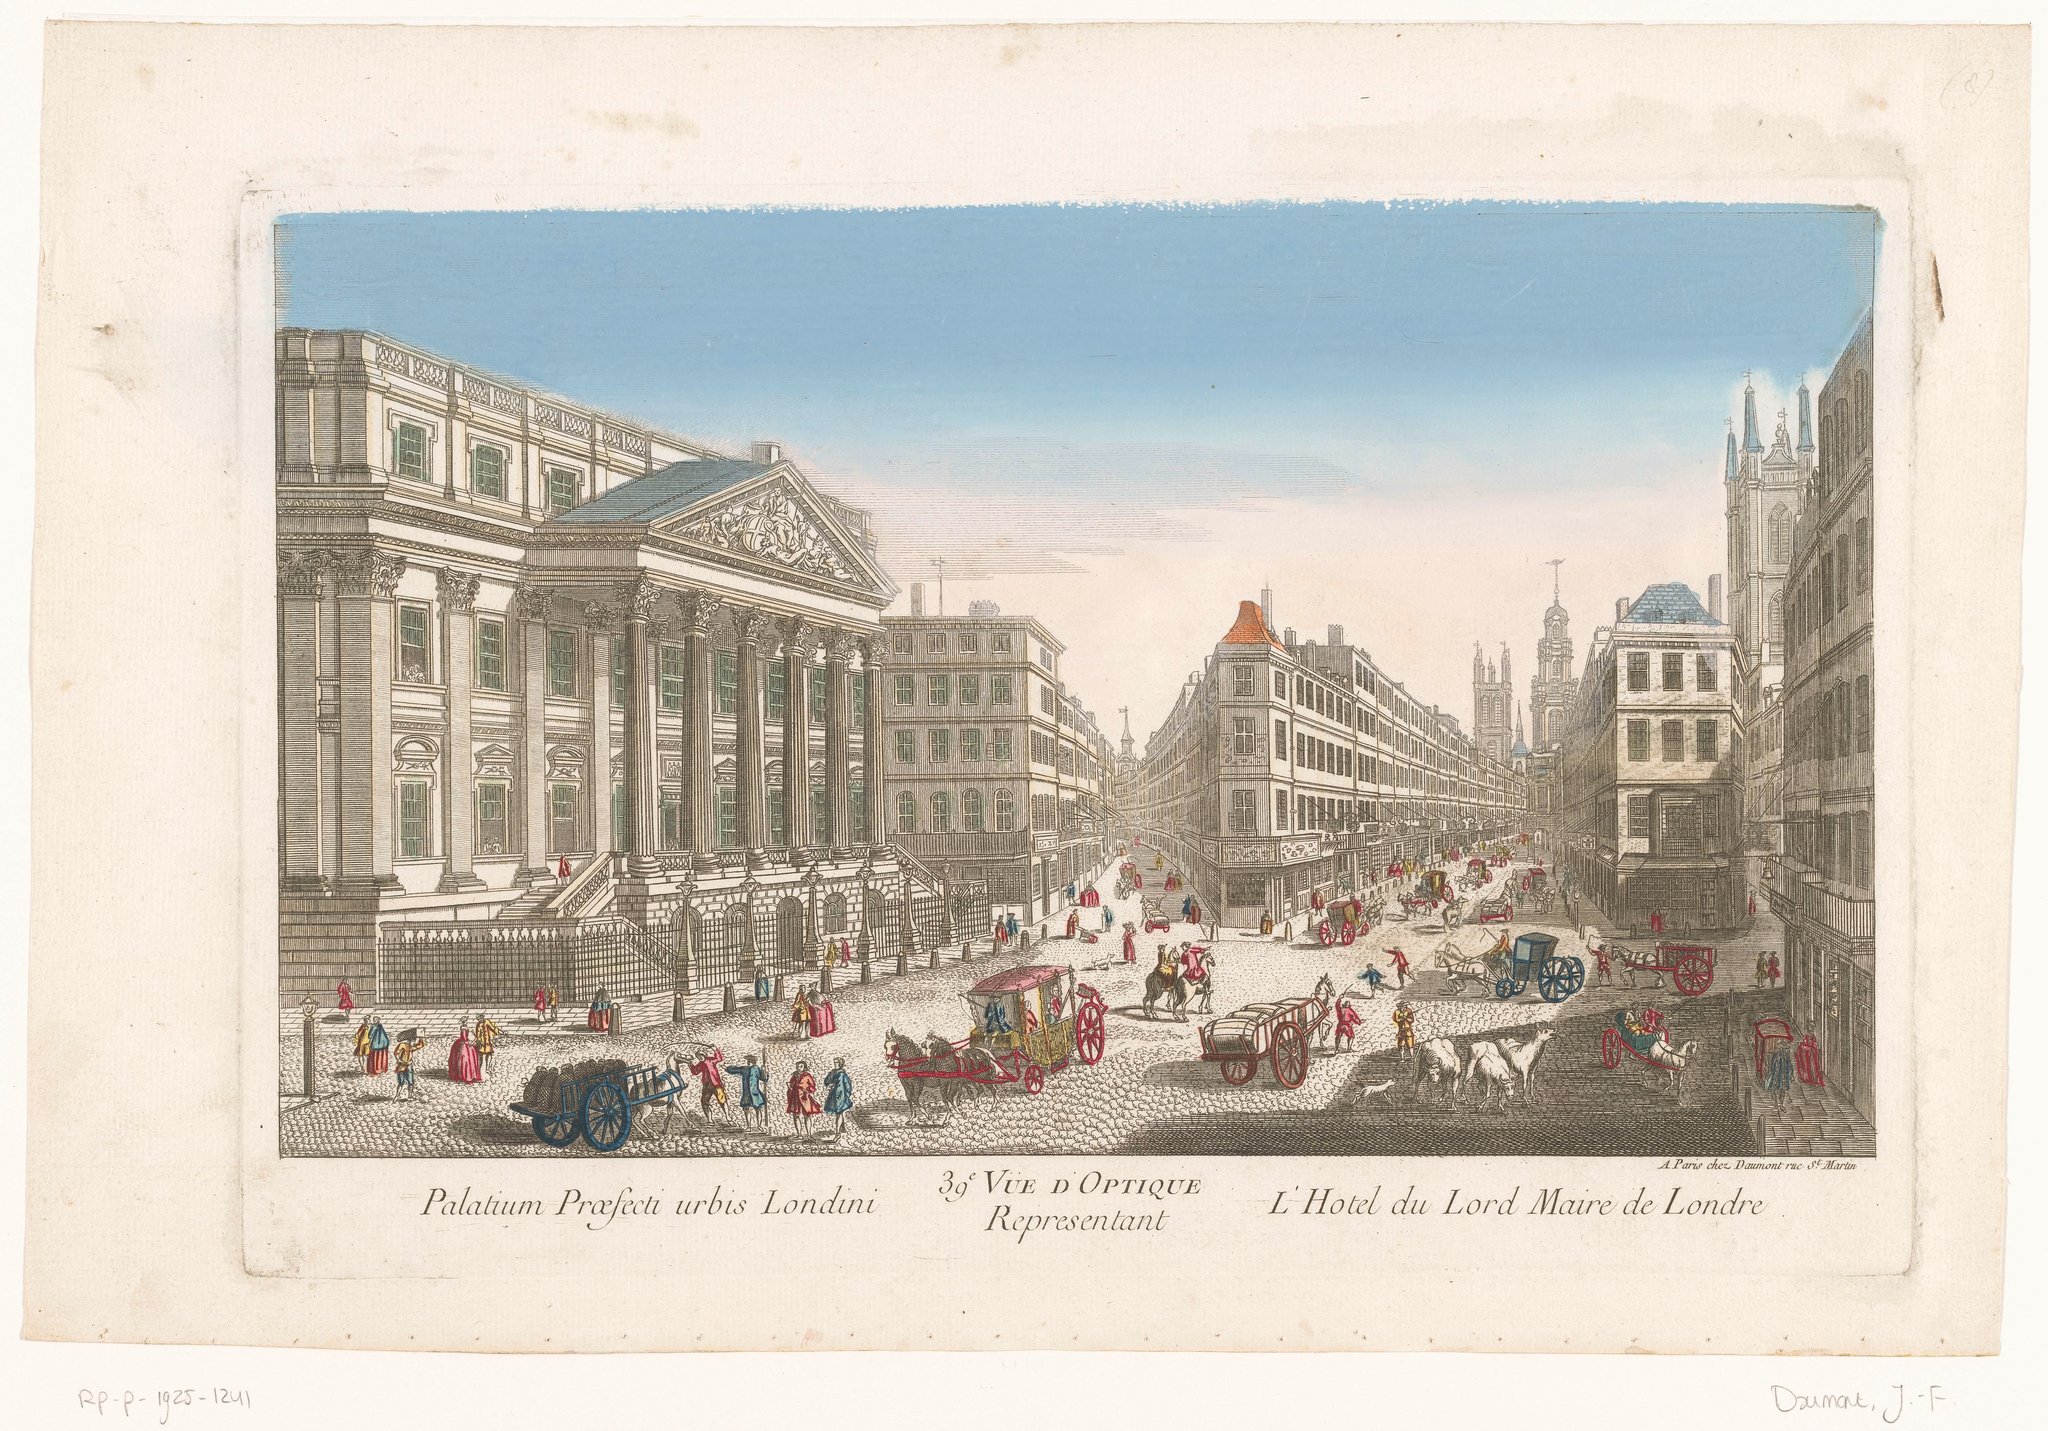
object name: opticaprent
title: Gezicht op het Mansion House te Londen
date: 1745-1775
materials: paper, watercolor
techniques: brush, etching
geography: france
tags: mayor, burgomaster, civic architecture; edifices; dwellings, street (+ city(-scape) with figures, staffage)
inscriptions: watermark, collector's mark: Lugt 2166